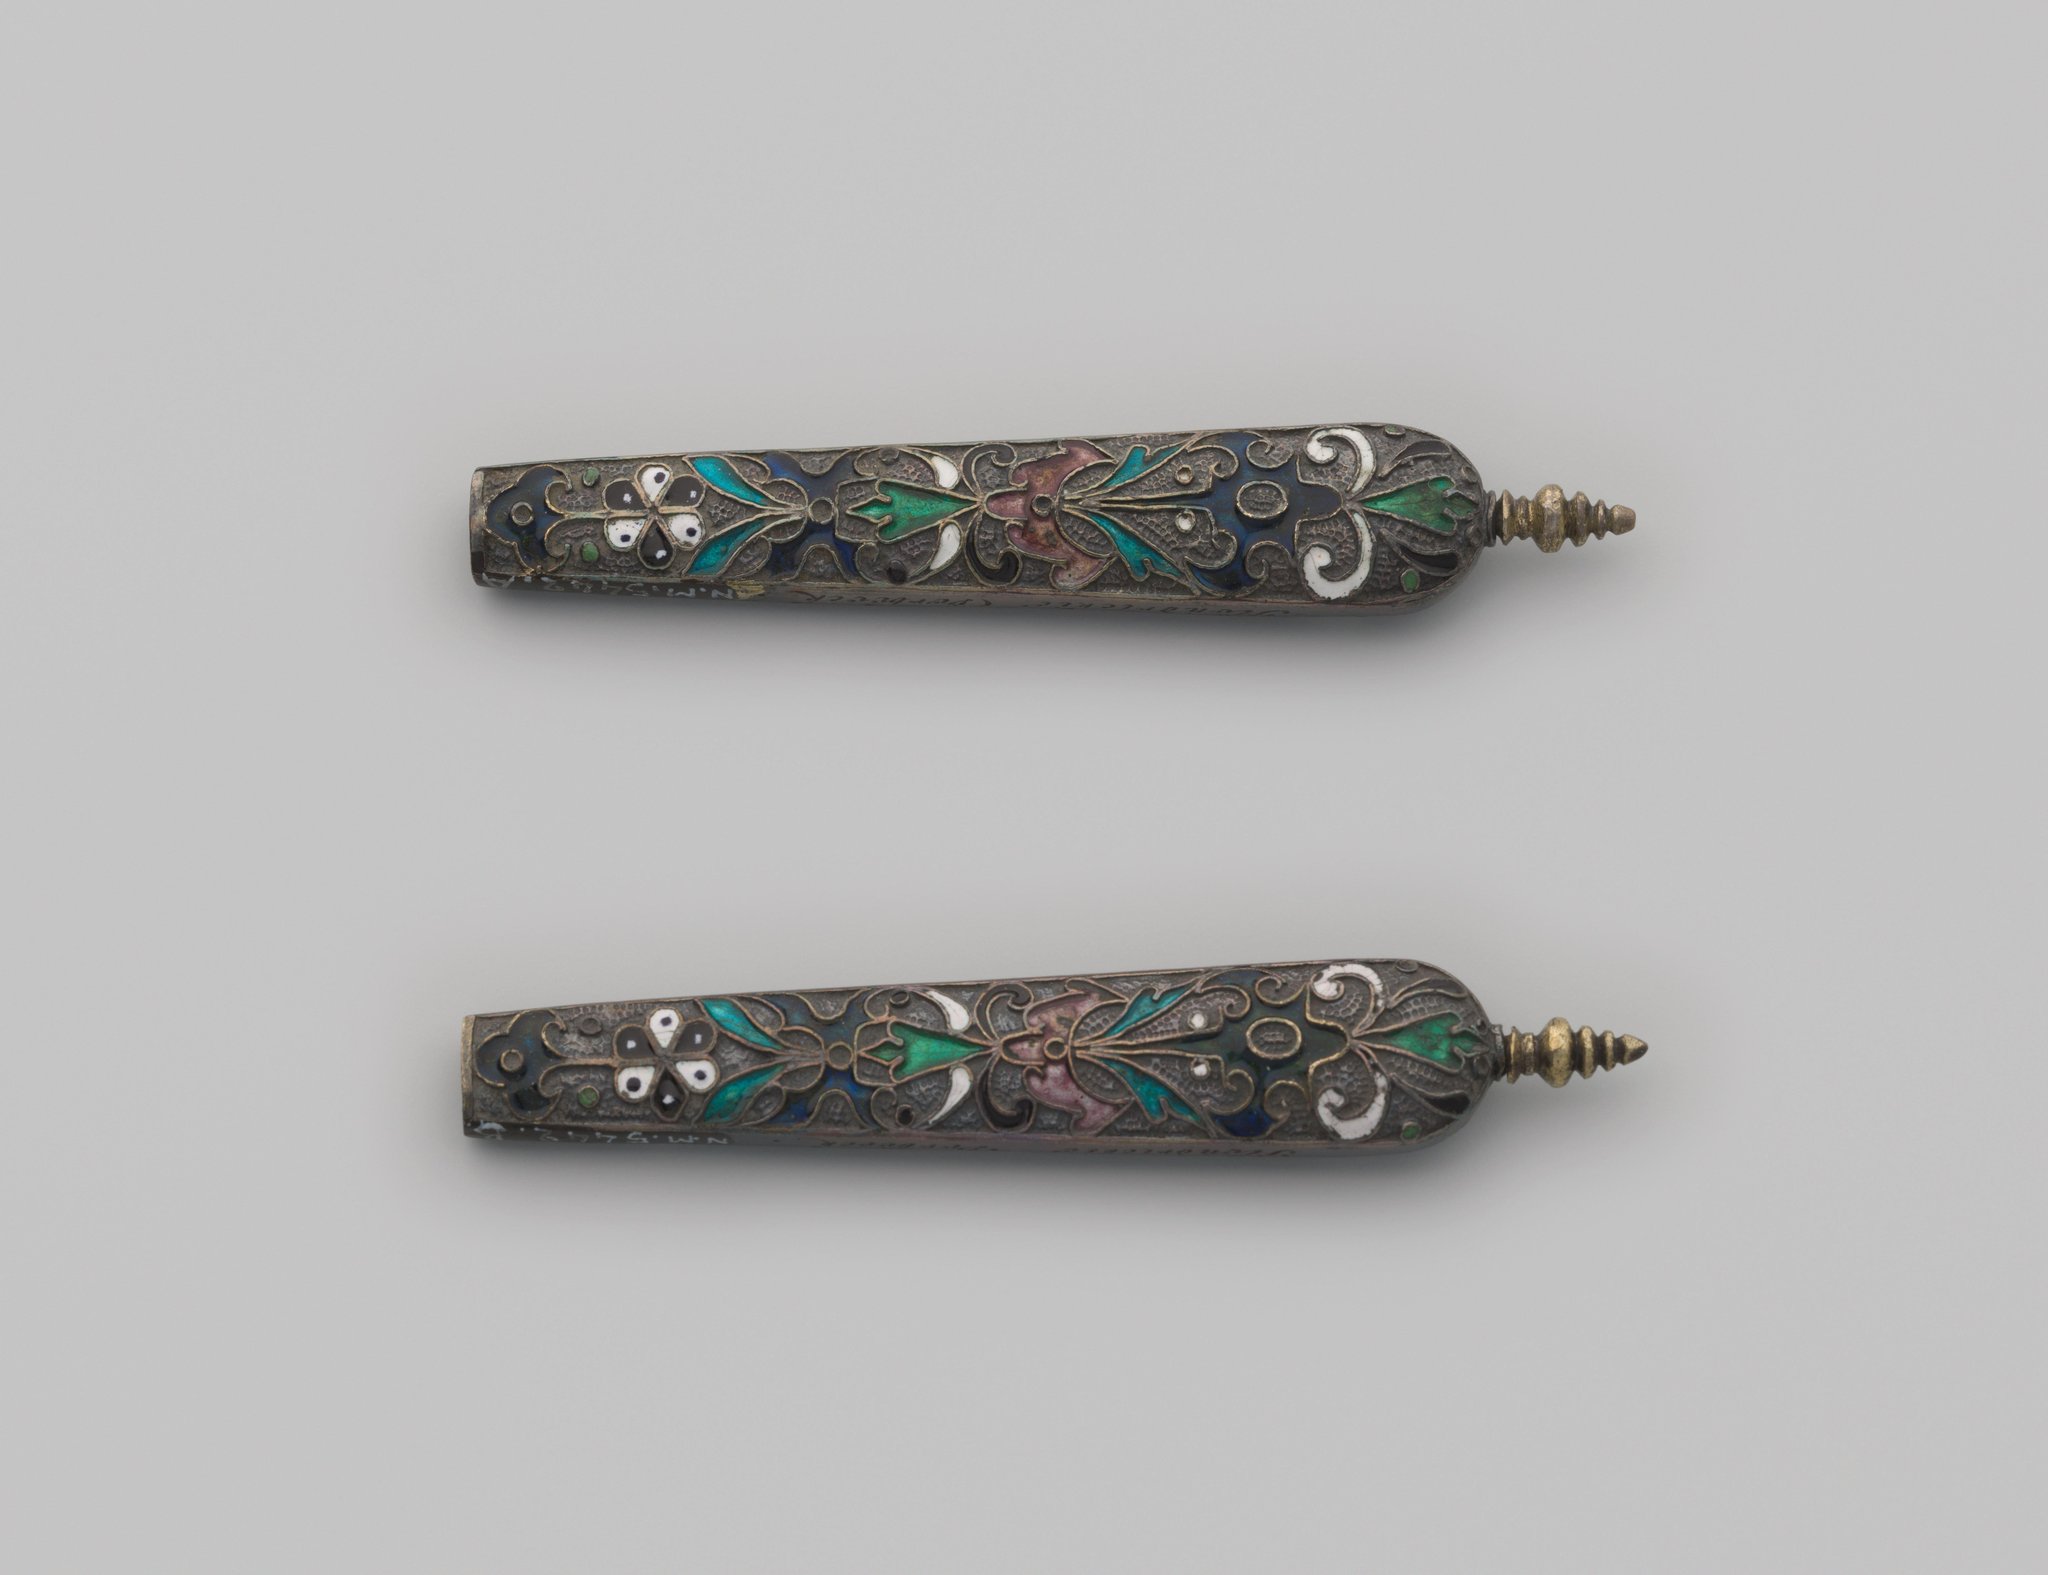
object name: haft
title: Heft van verguld zilver, met uiteinde in de vorm van ronde knop. Versiering in email-cloisonné. Op zijkant gegraveerd: Hendrickie Verbeeck/Stil van tong : en gau in hooren.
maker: Anonymous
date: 1600-1625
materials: silver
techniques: gilding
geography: northern netherlands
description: Heft van verguld zilver. Het uiteinde wordt bekroond met een rond knopje. De 2 zijden zijn versierd met motieven in cloisonné émail. Op de zijkant gegraveerd: Hendrickie Verbeeck / Stil van tong : en gau in hooren.